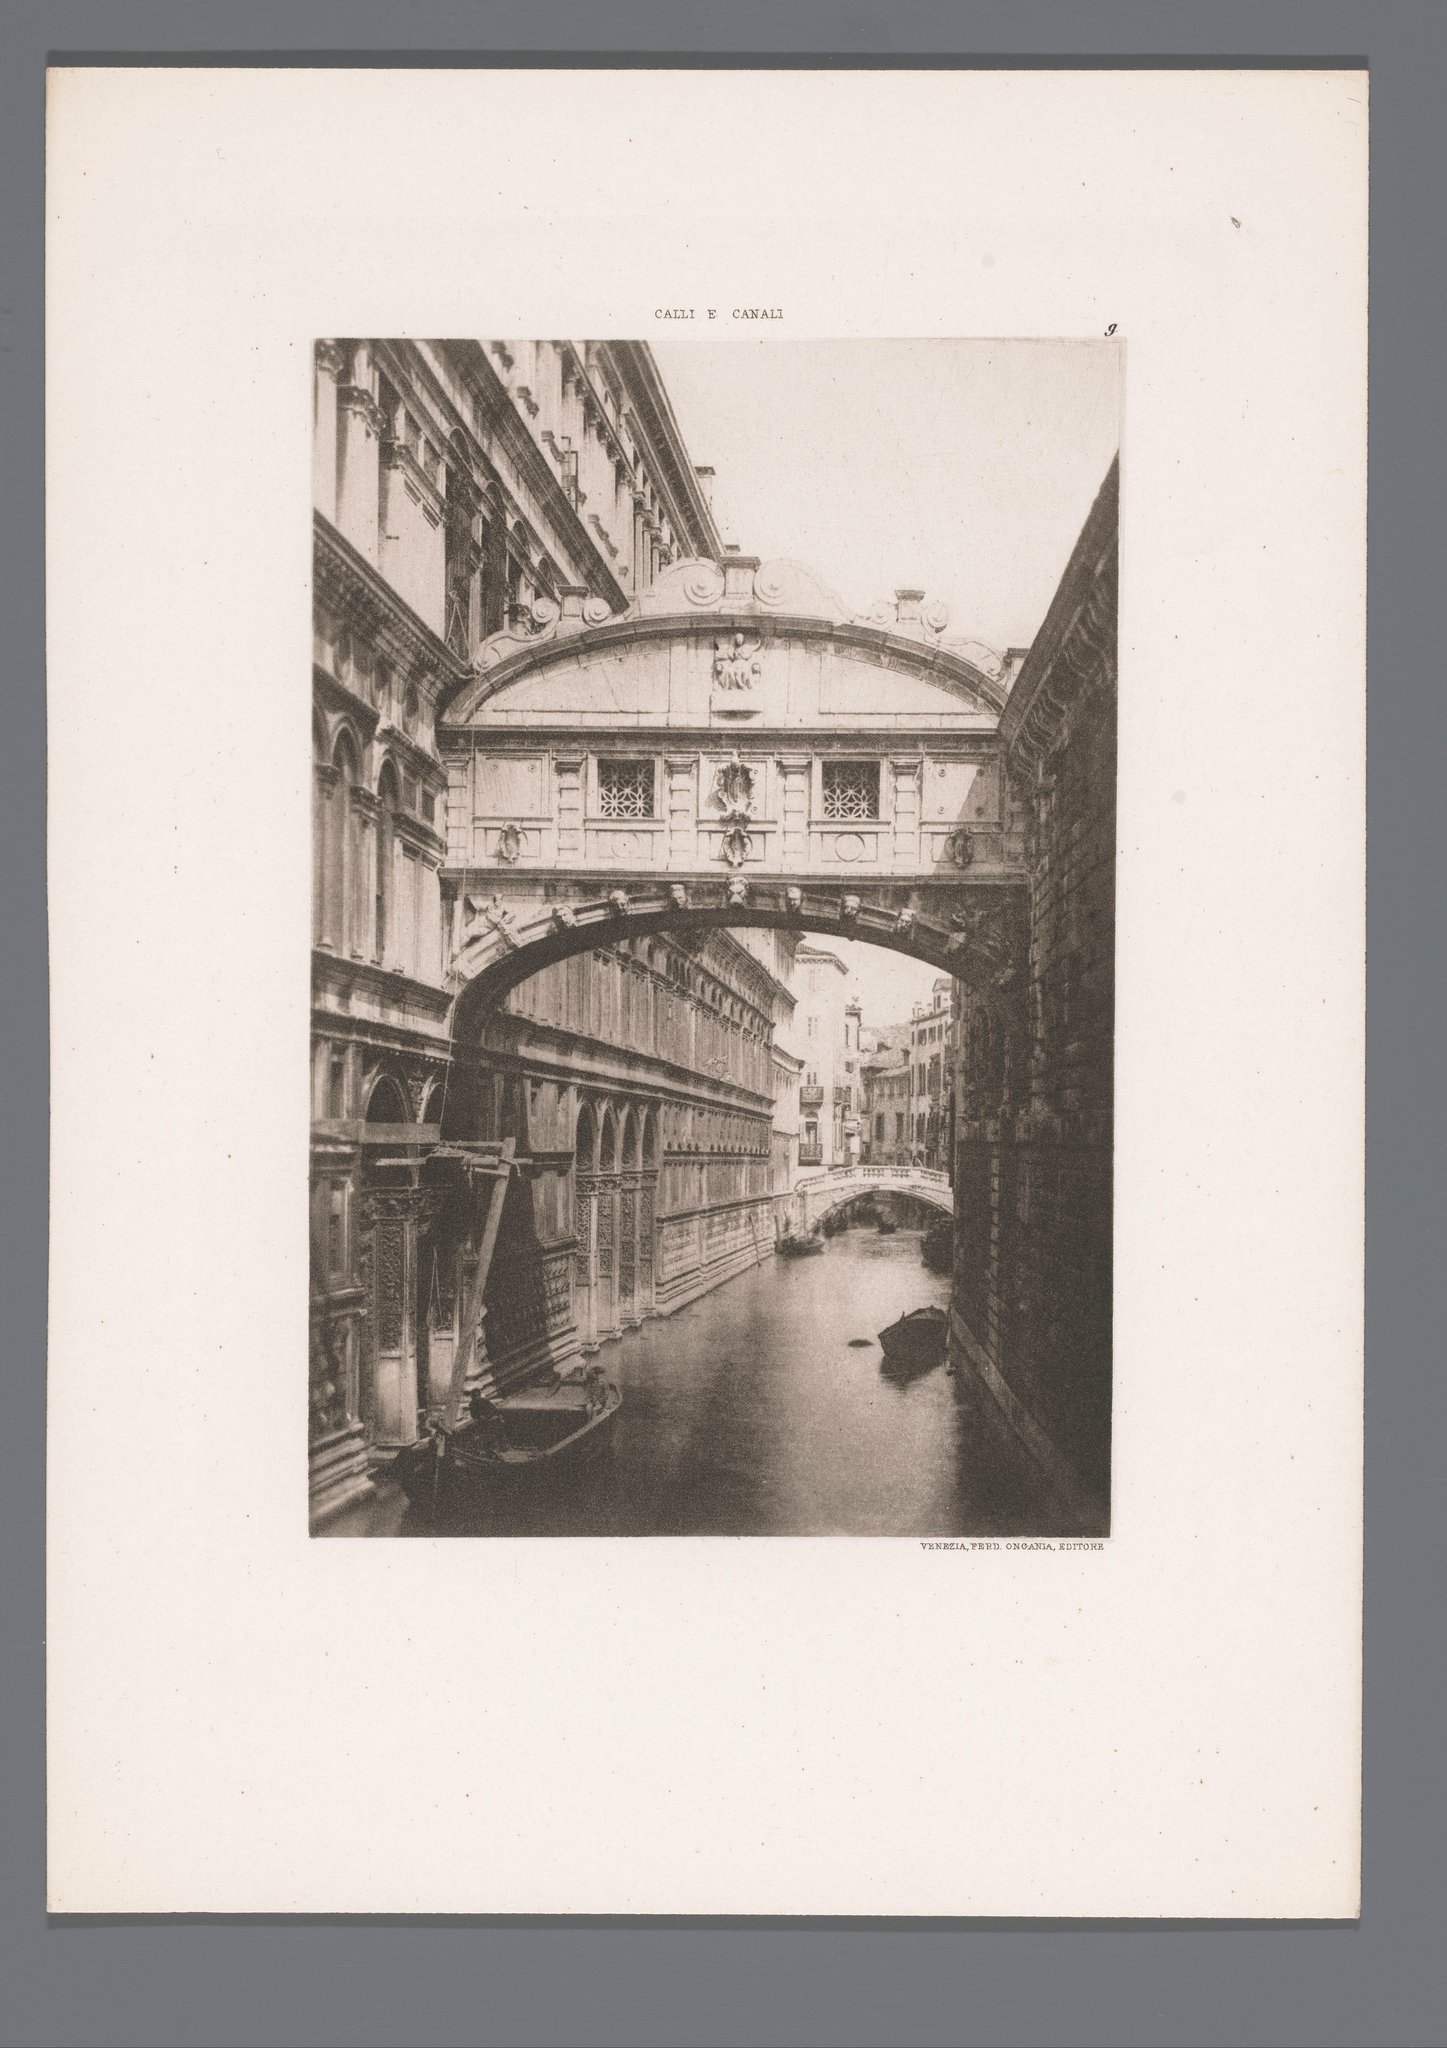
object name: page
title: Gezicht op de Ponte dei Sospiri in Venetië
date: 1888-1898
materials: paper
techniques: photoaquatint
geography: venice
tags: bridge, gondola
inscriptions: inscription: ‘g’